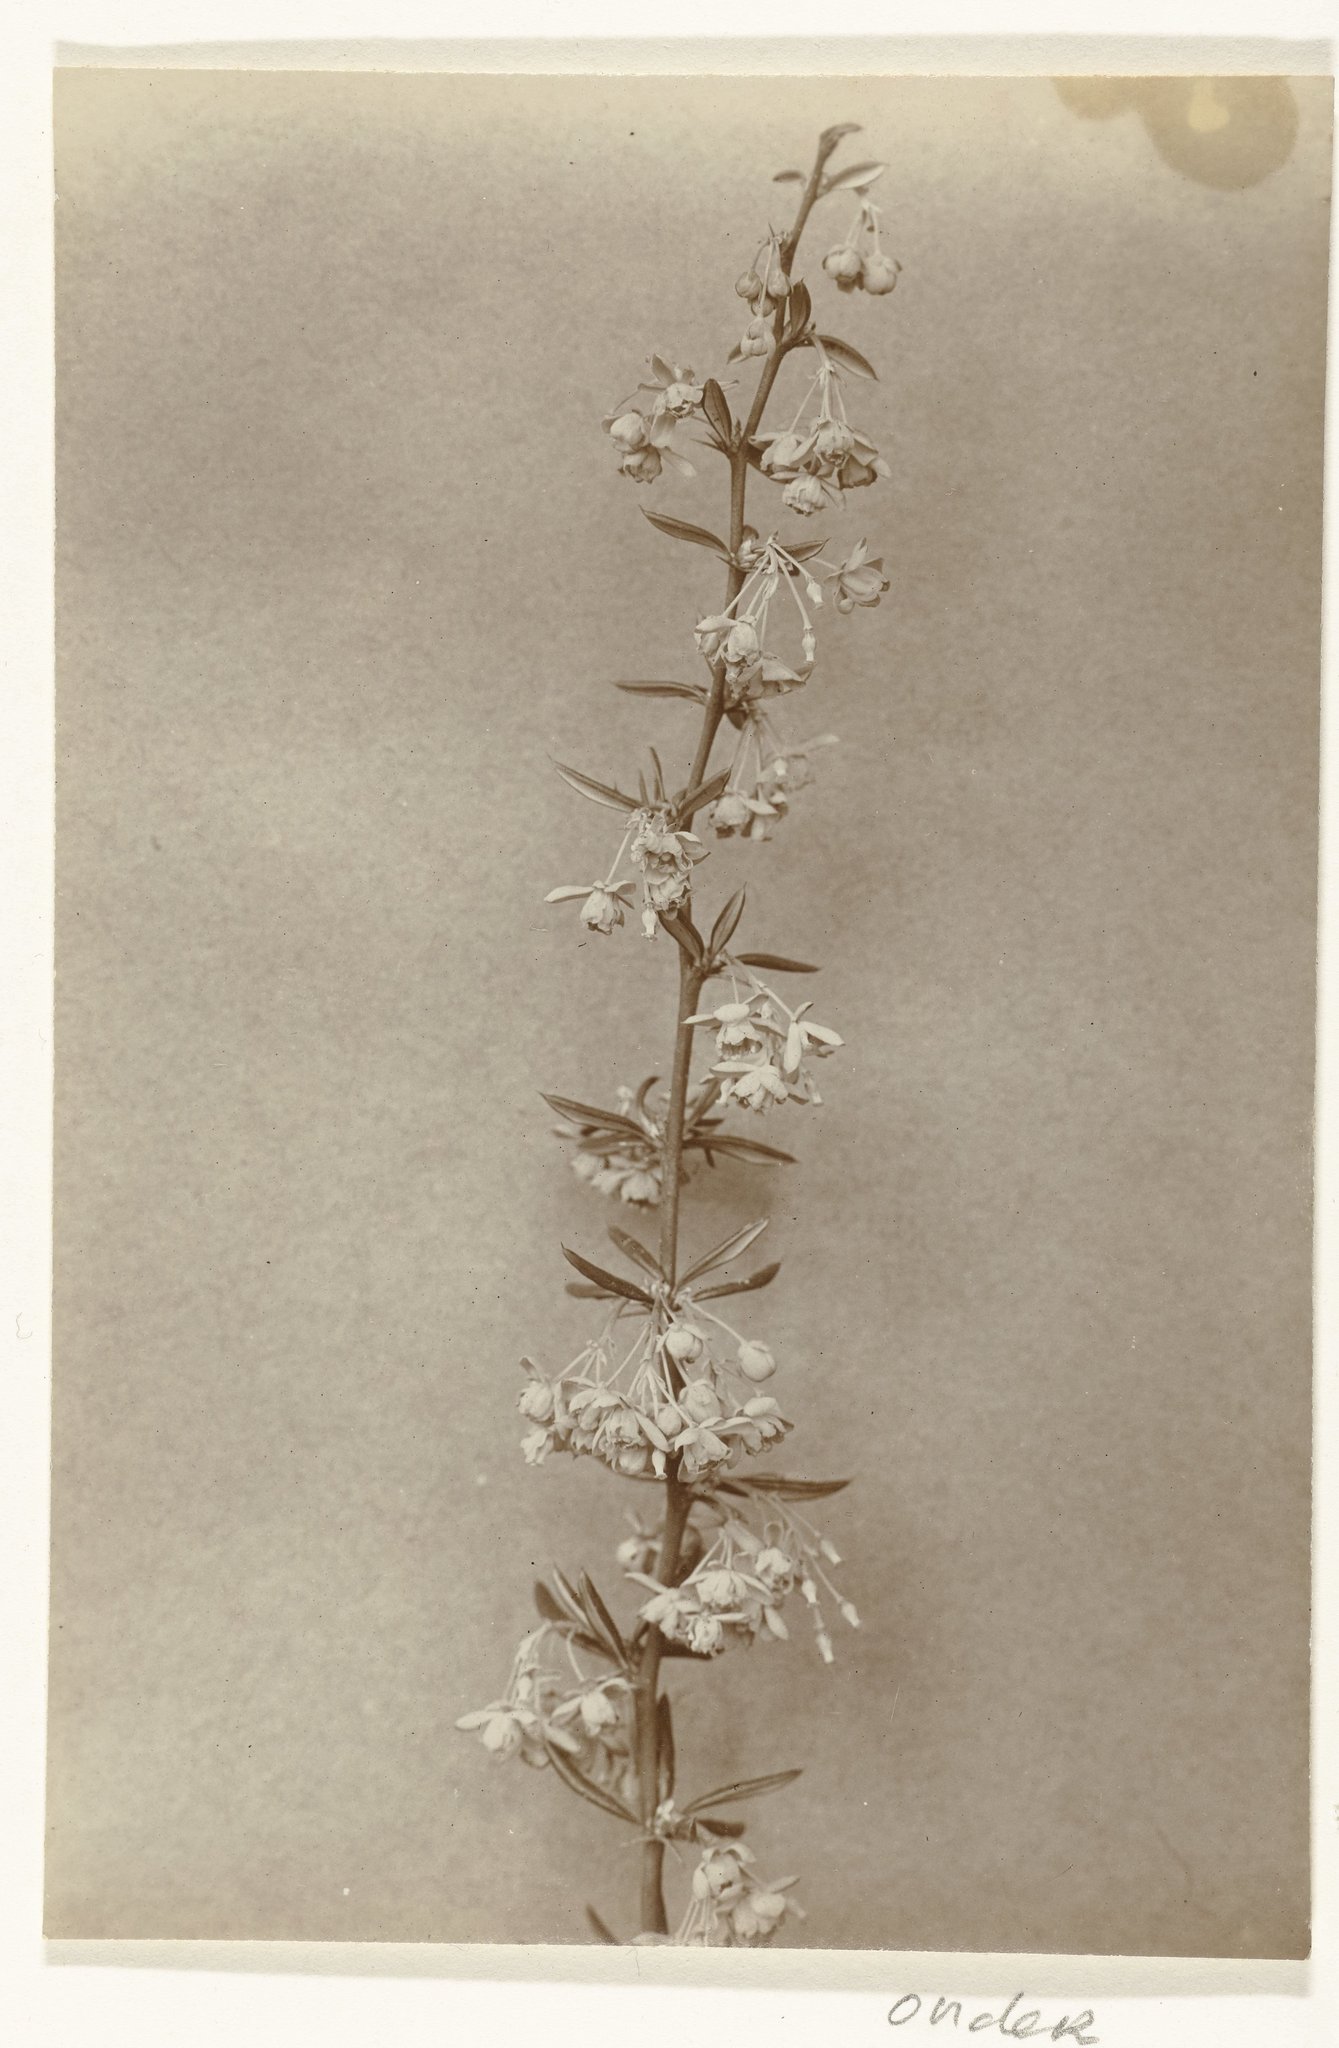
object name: photograph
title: Takken van een zuurbes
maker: richard tepe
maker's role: fotograaf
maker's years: 1864-1952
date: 1900-1930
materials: photographic support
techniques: gelatin silver print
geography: apeldoorn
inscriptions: signature: ‘foto / R Tepe’, annotation: ‘Berberis Stenophylla’